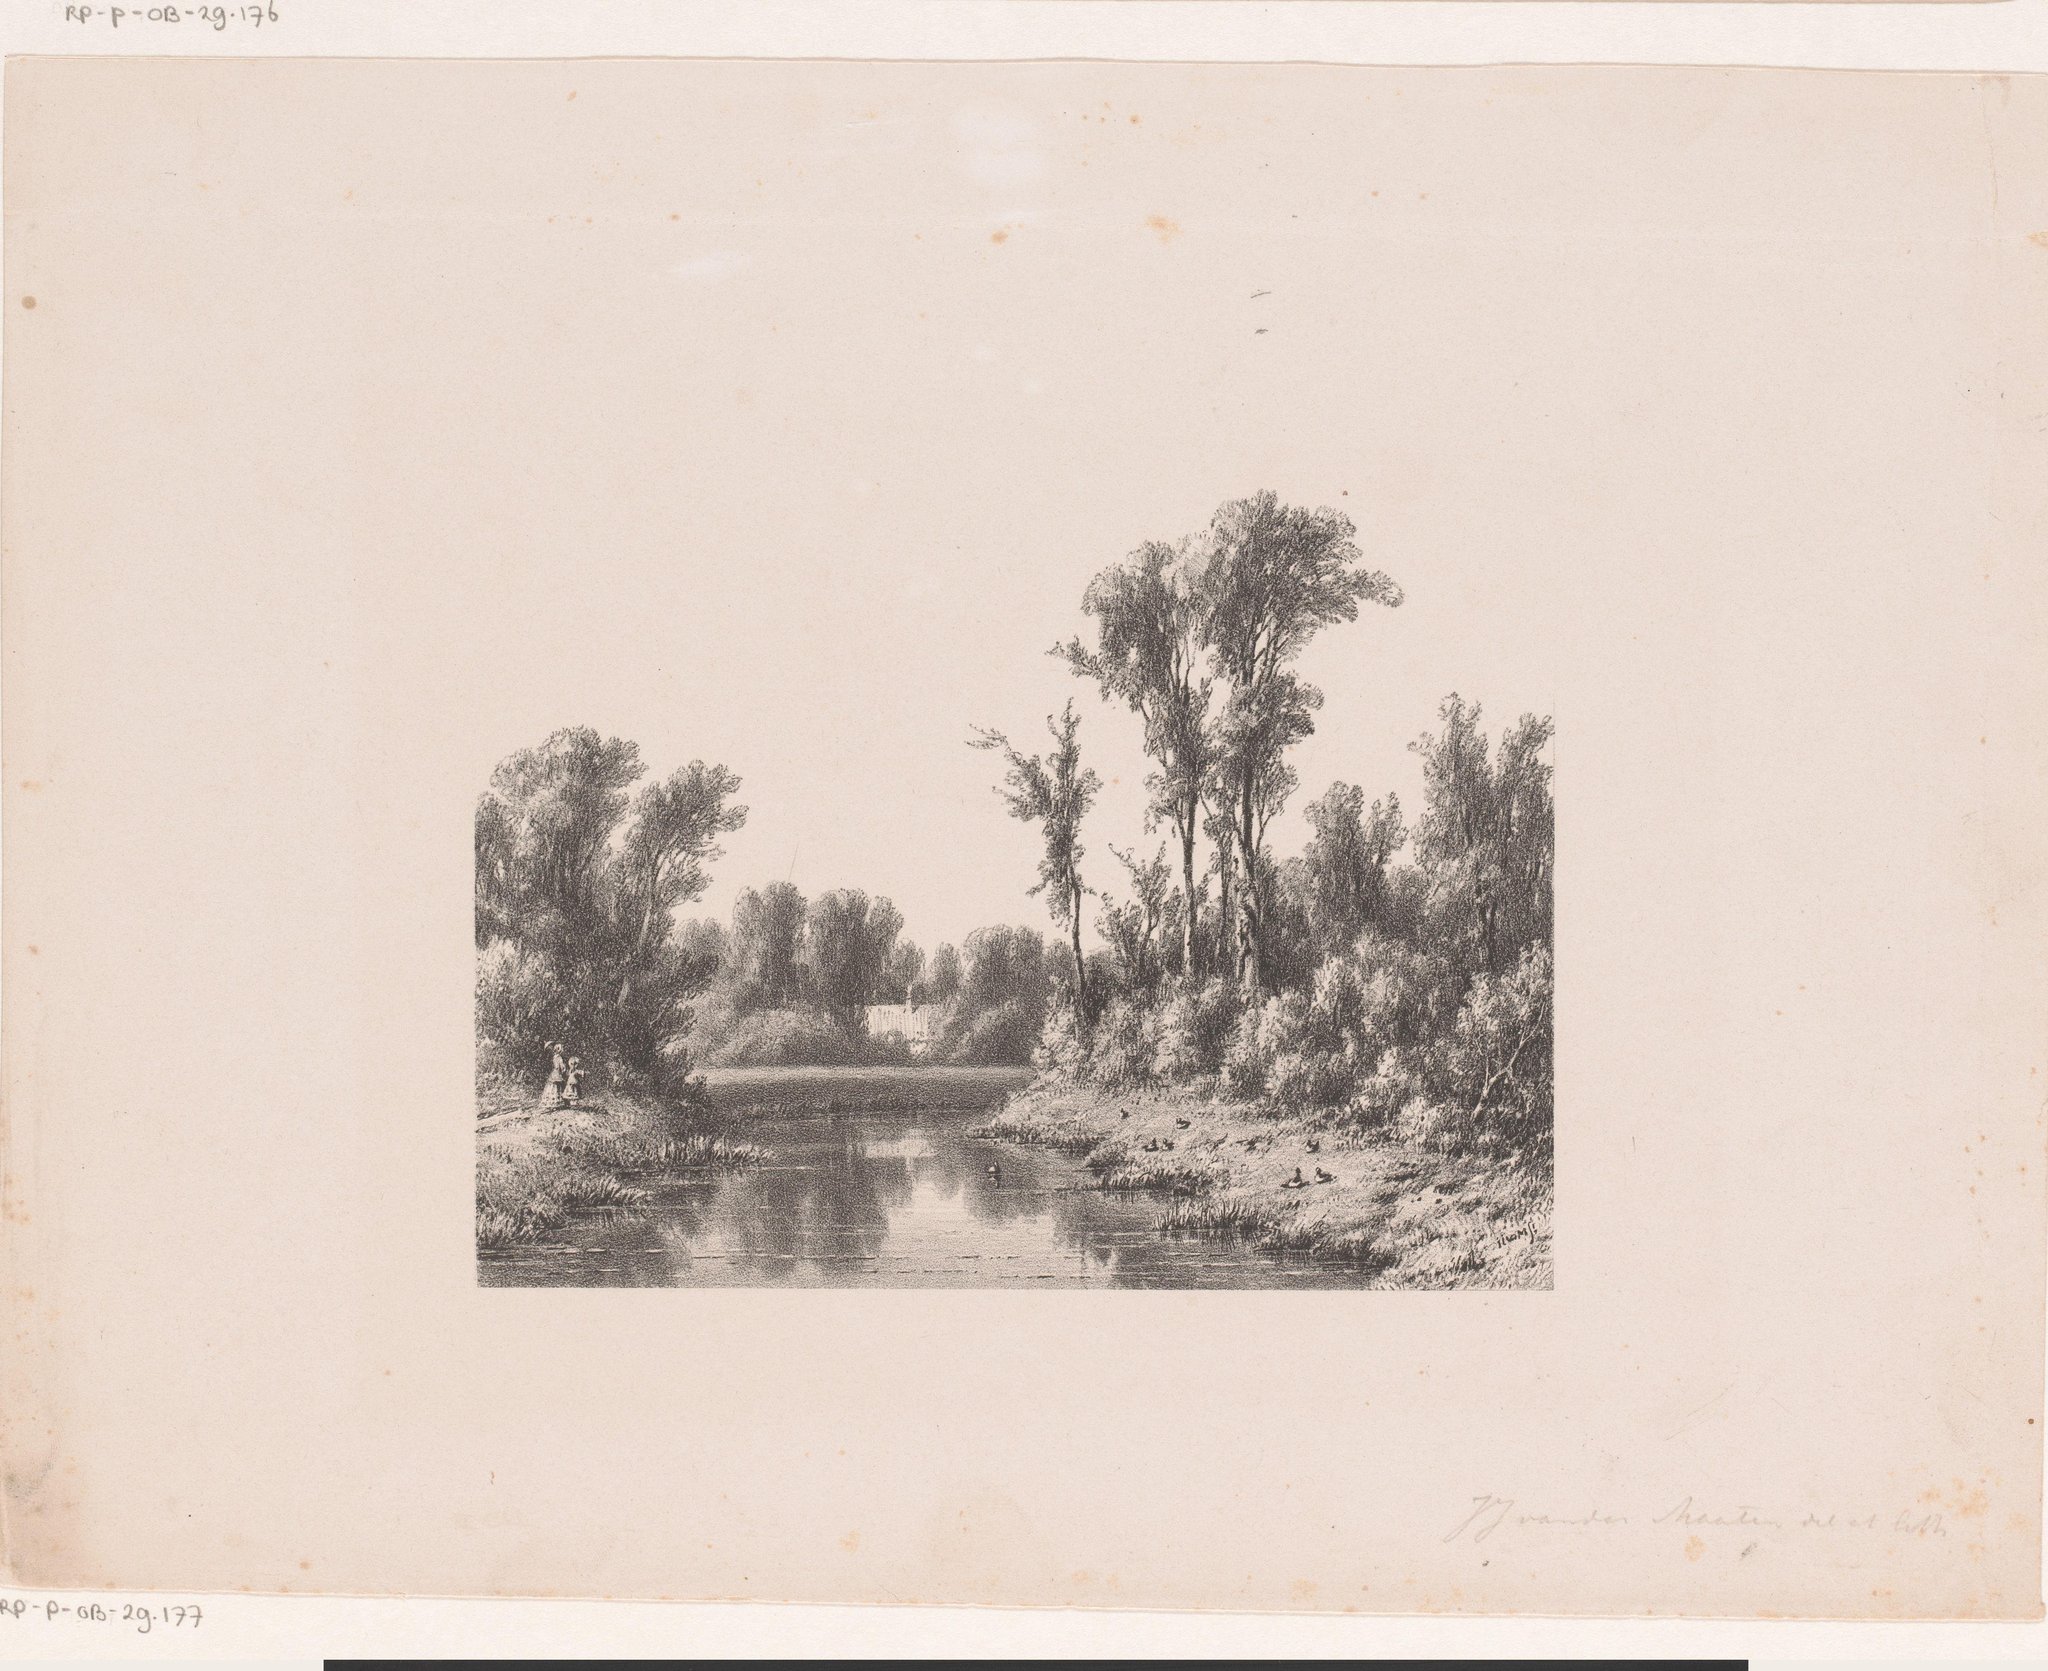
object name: print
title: Landschap met rivier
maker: jacob jan van der maaten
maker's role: draughtsman, print maker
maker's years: 1820-1879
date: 1830-1879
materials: paper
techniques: lithograph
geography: the hague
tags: strolling, river (+ landscape with figures, staffage), farm or solitary house in landscape, water-birds: duck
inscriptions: collector's mark: Lugt 2228, inscription: ‘J J van der Maaten del et lith’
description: Links van de rivier wandelen een vrouw en meisje. Rechts aan de waterkant eenden. In de verte tussen de bomen staat een huis.